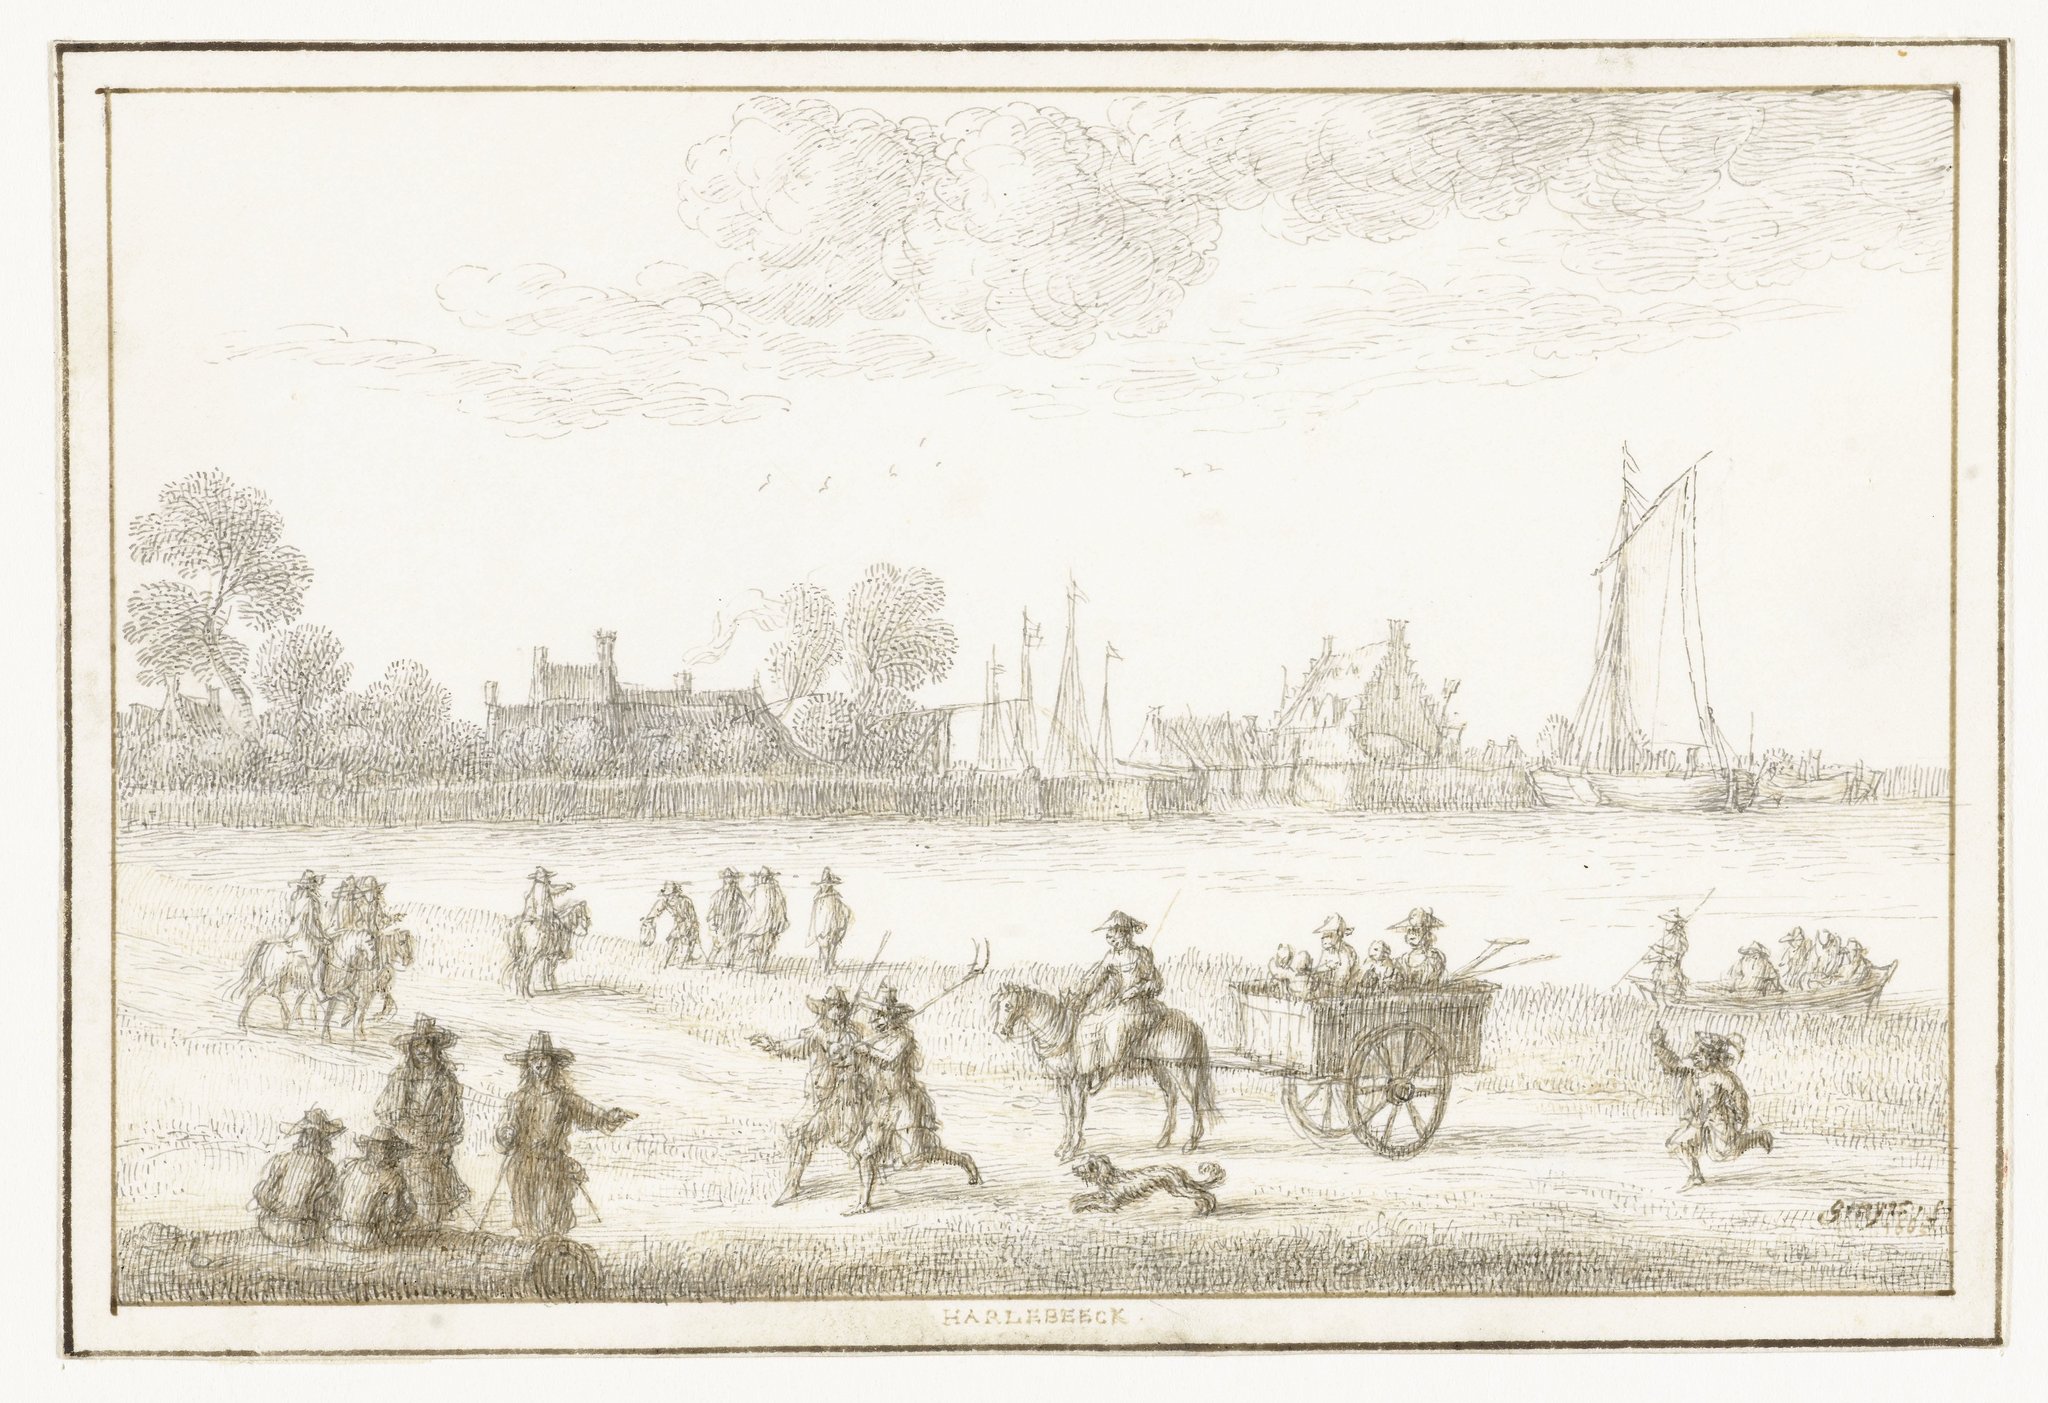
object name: drawing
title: Gezicht op het dorp Harlebeeck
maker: gilles neyts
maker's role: draughtsman, print maker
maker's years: 1623-1687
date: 1665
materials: ink, parchment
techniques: pen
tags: prospect of village, silhouette of village